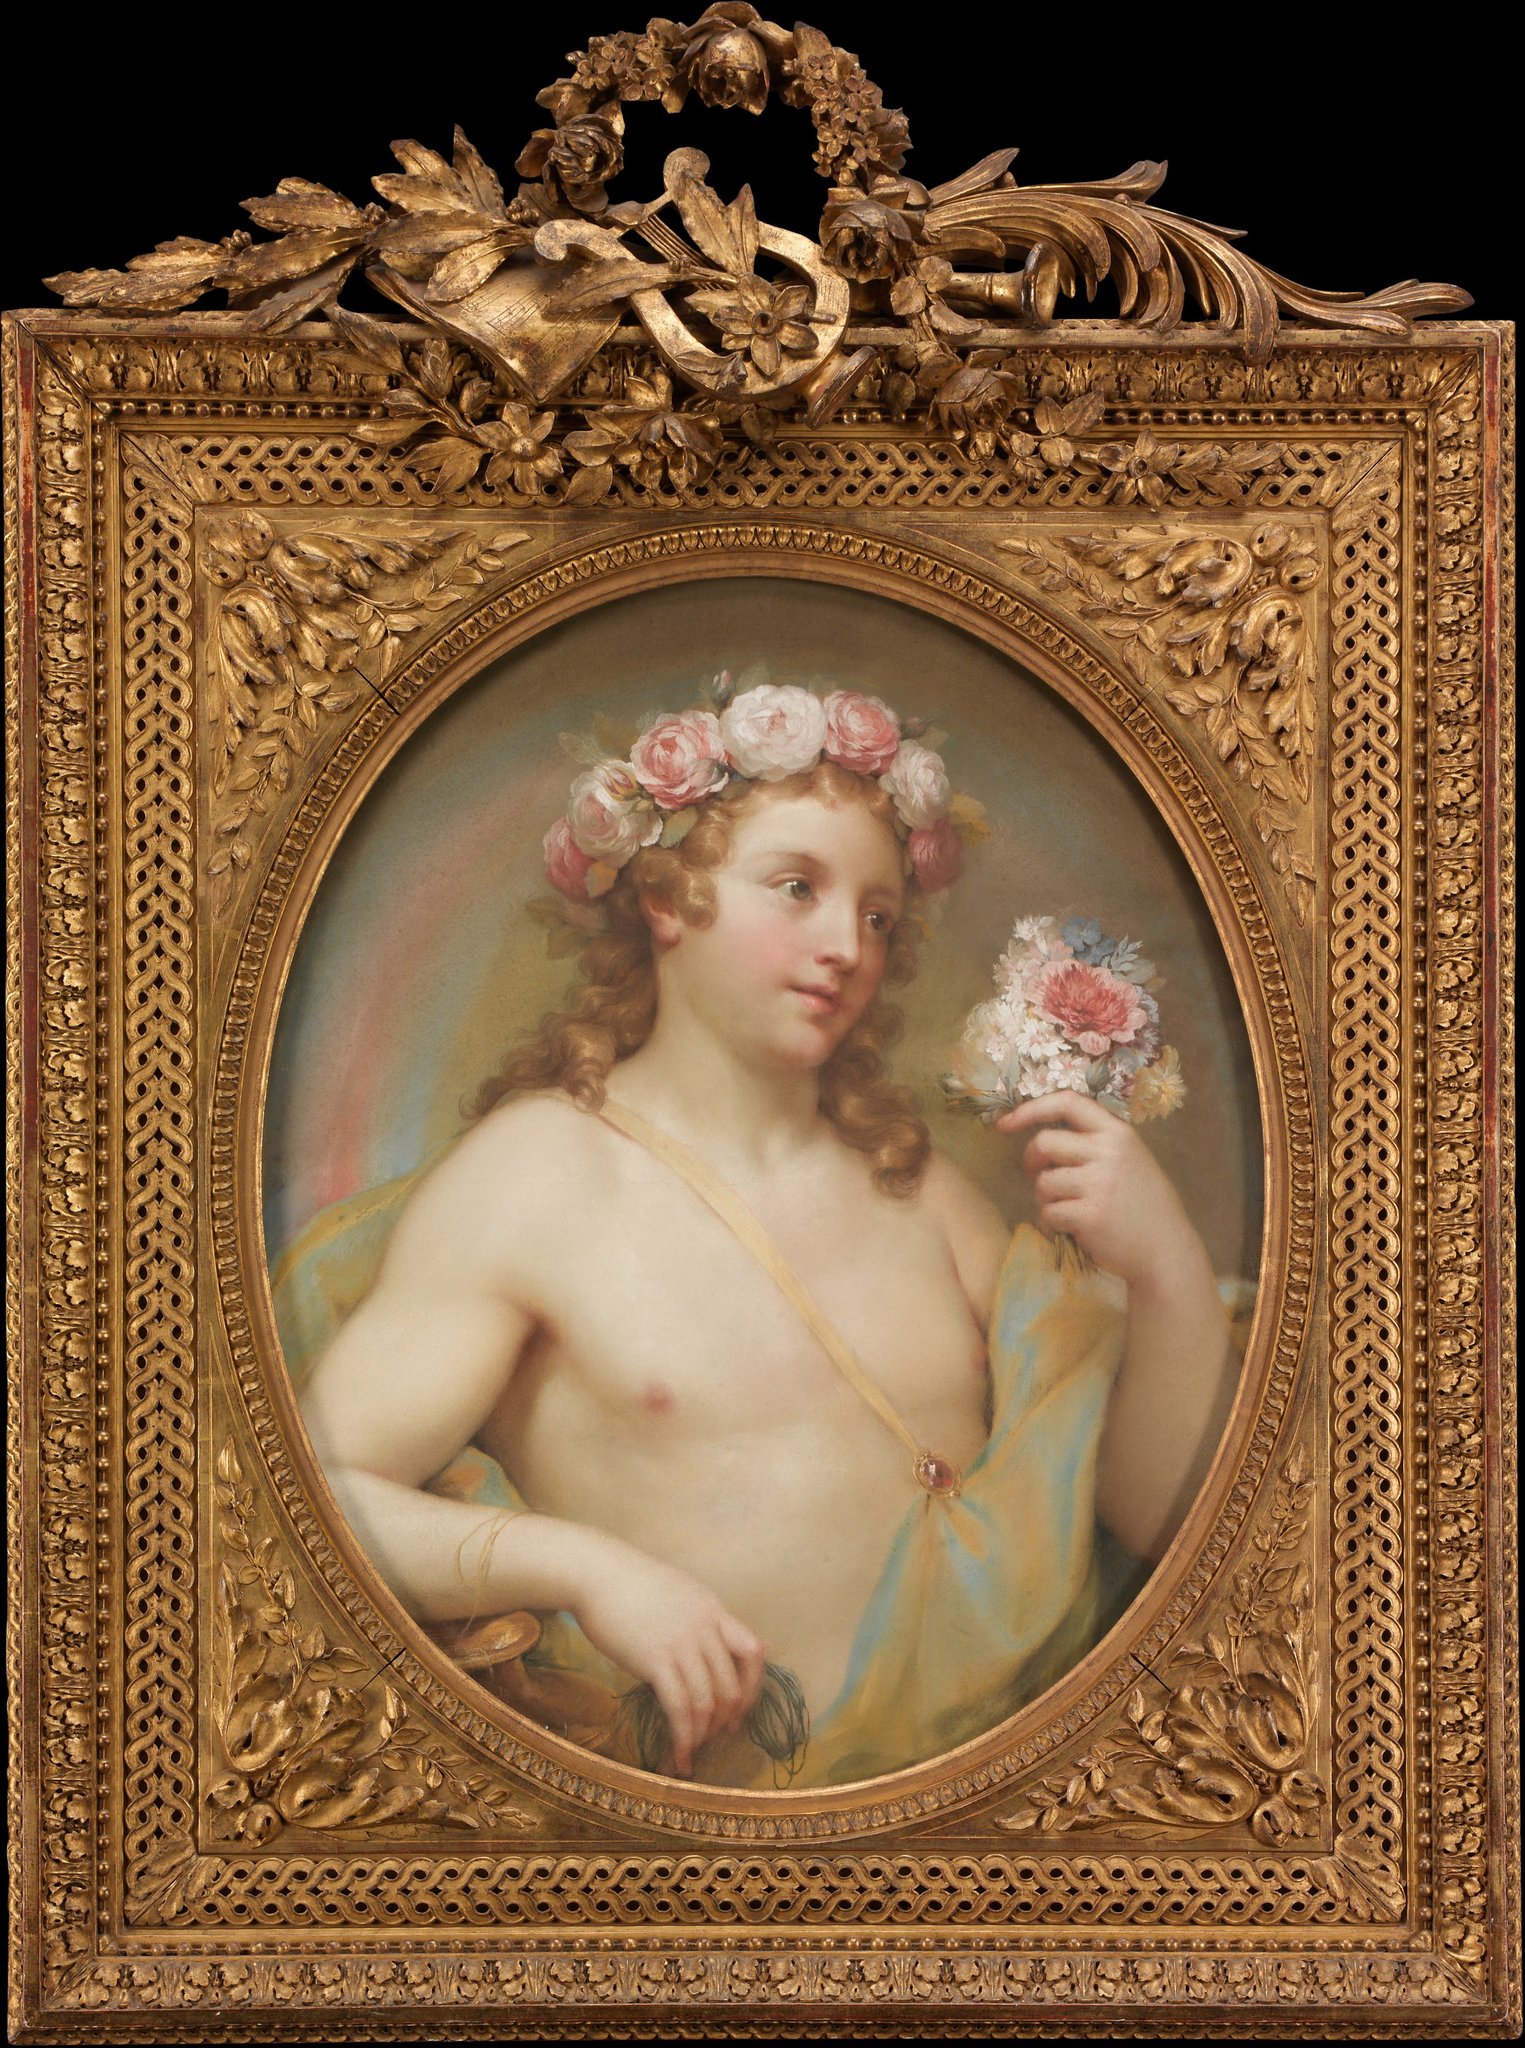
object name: painting, drawing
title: Pleasure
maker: anton raphael mengs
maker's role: artist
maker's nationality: german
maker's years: 1728-1779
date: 1754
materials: canvas, paper, pastel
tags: boys,flowers